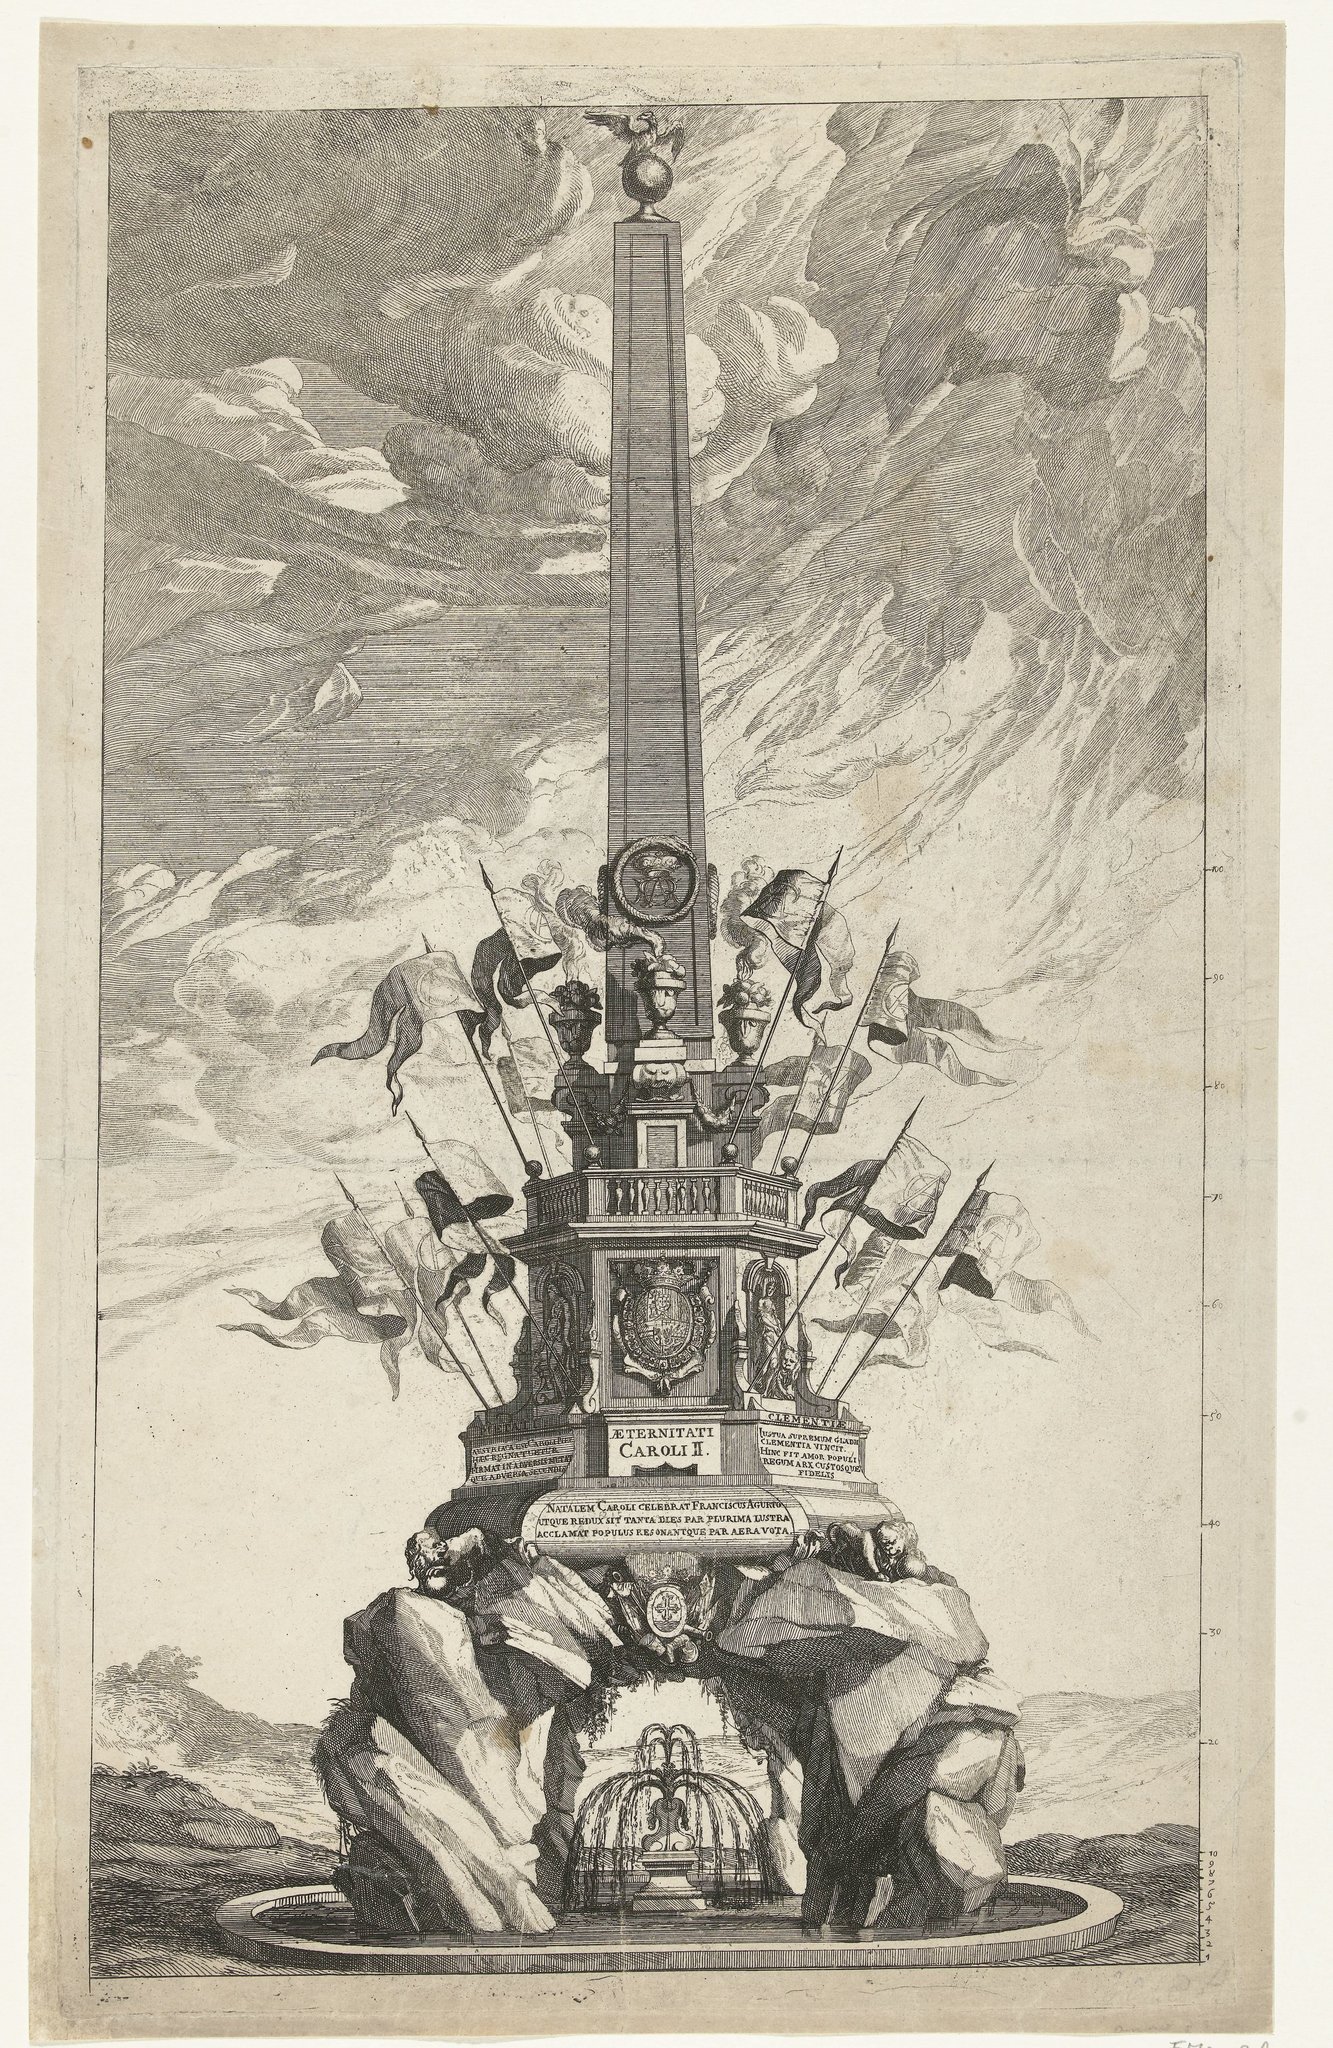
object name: print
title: De katafalk voor de overleden Spaanse koning Karel II, 1700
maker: Anonymous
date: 1700-1701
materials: paper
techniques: etching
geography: low countries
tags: karel ii (koning van spanje), catafalque, 'castrum doloris' (~ public funeral)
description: De katafalk in de vorm van een obelisk op een rotsgroep met fontein, opgericht voor de op 1 november 1700 overleden Spaanse koning Karel II. Versierd met vaandels, wapens, allegorische figuren en Latijnse spreuken. Aan de rechterzijde van de kader een schaalaanduiding.